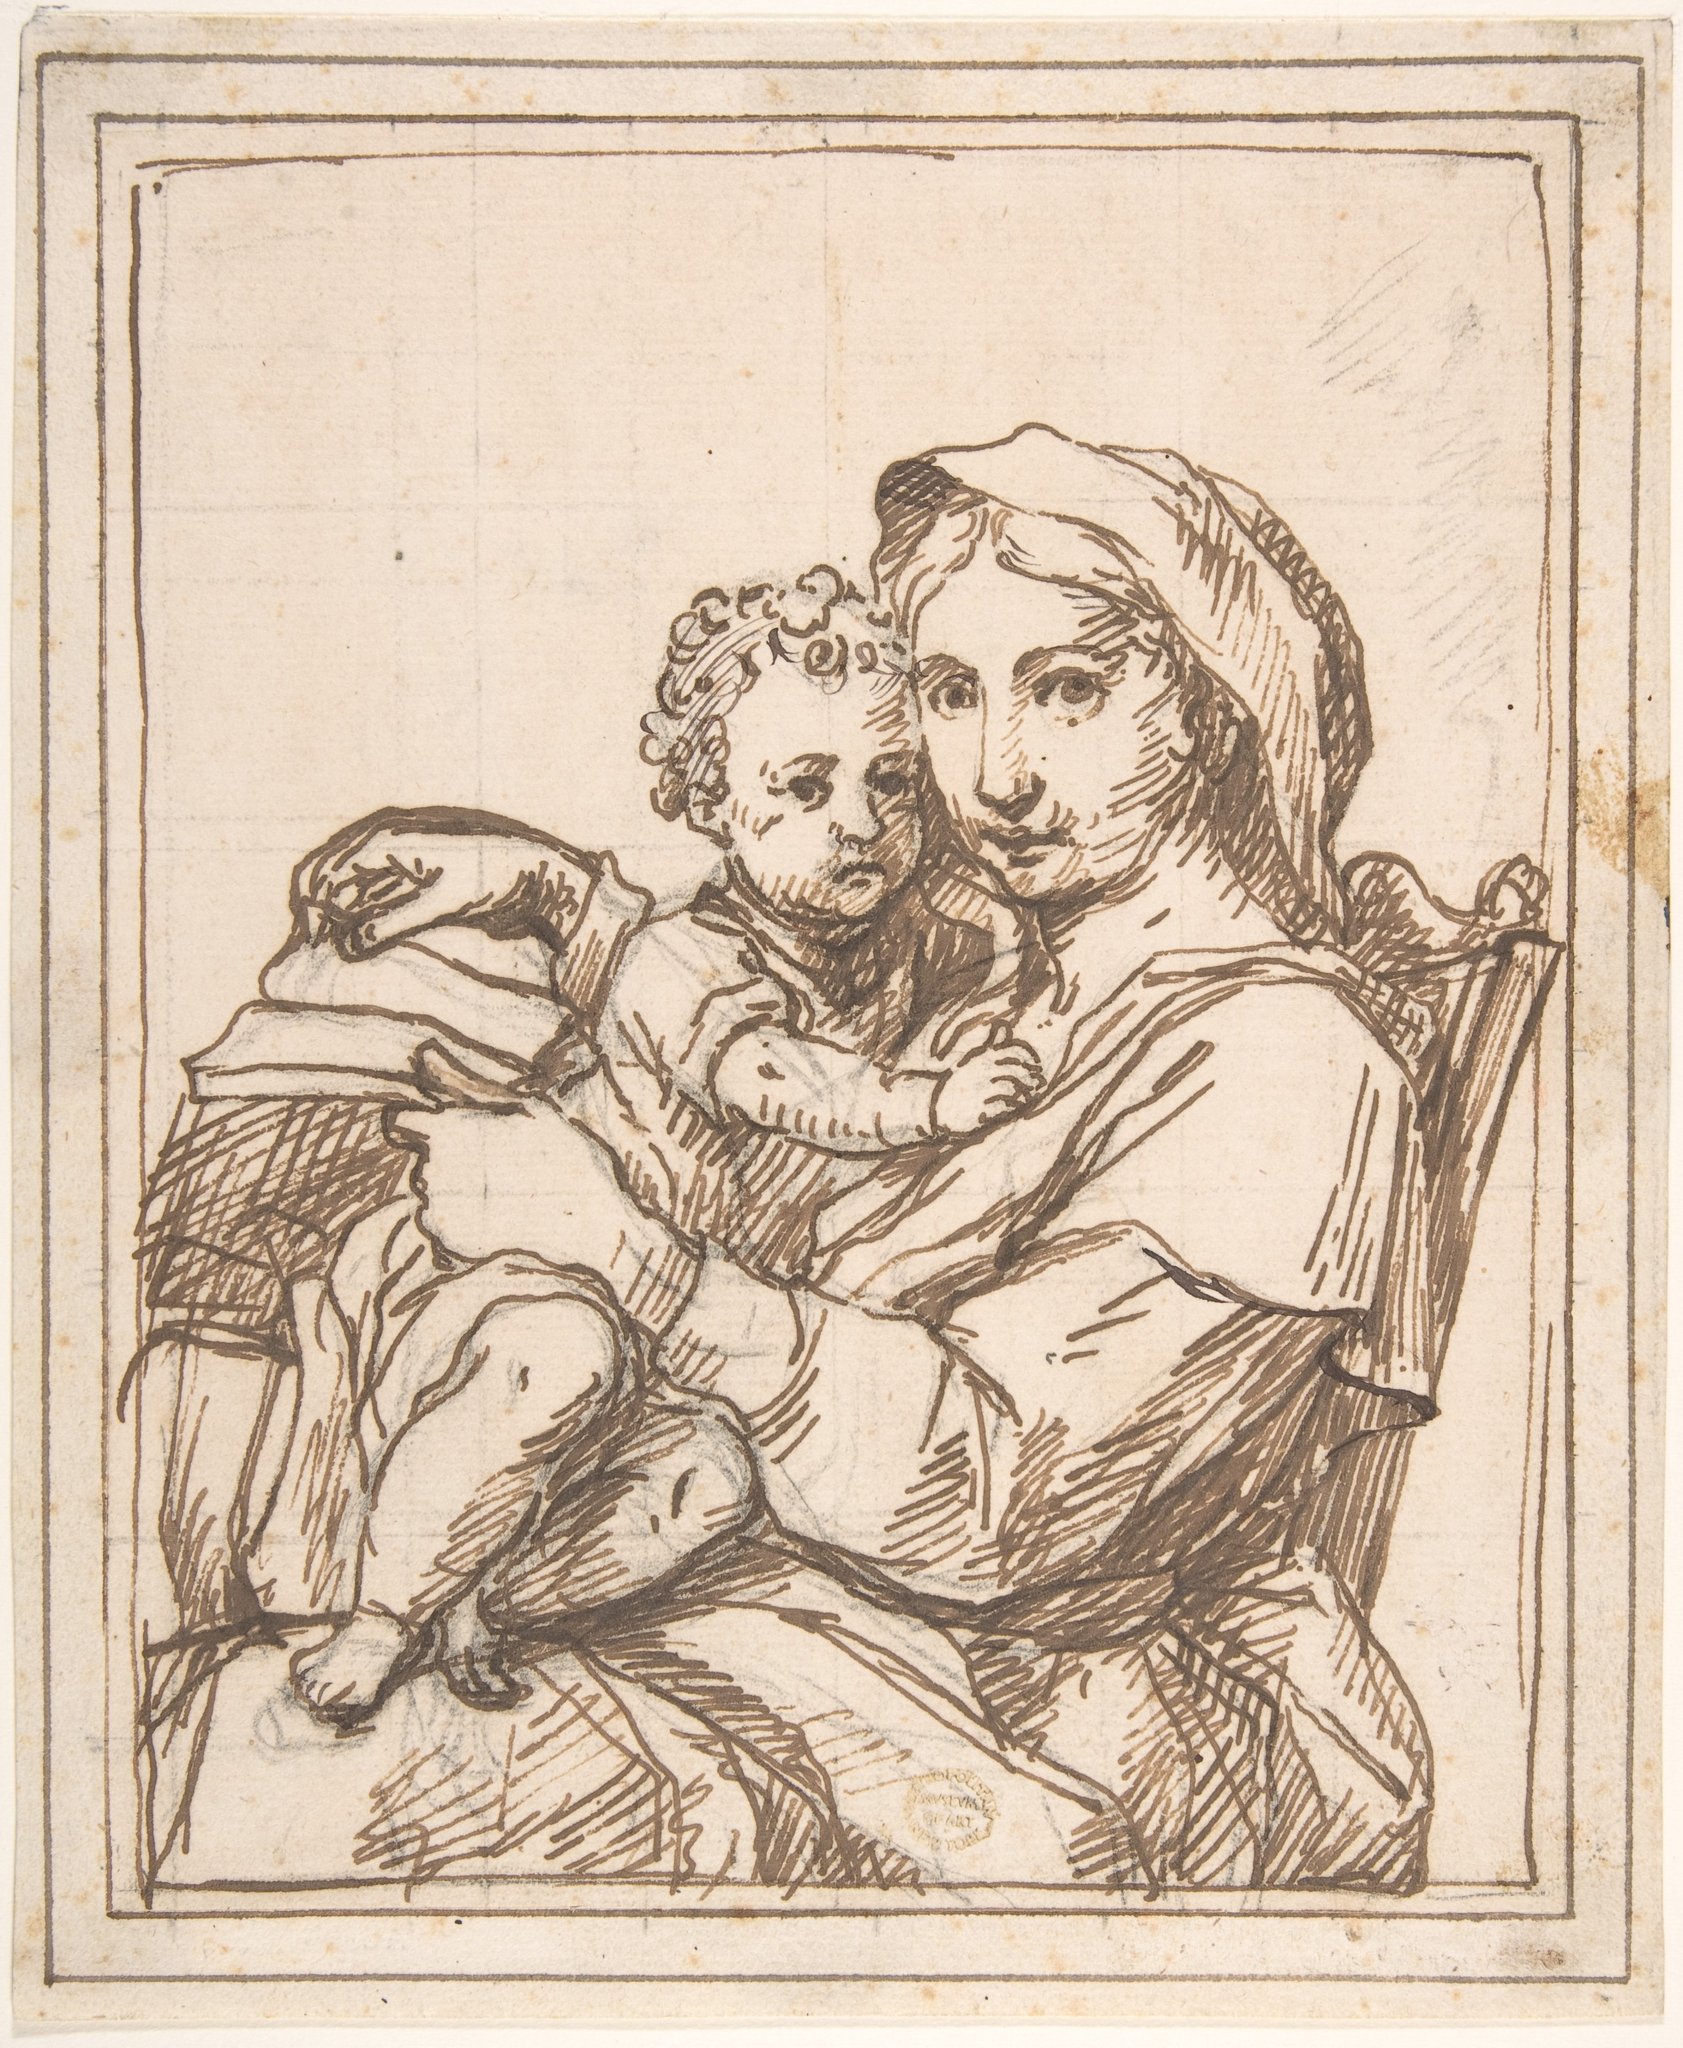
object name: drawing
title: Madonna and Child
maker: anonymous, italian, roman-bolognese, 17th century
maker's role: artist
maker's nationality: italian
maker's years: 1600-1700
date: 1601-1700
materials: chalk, ink, paper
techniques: pen, drawing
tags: madonna and child